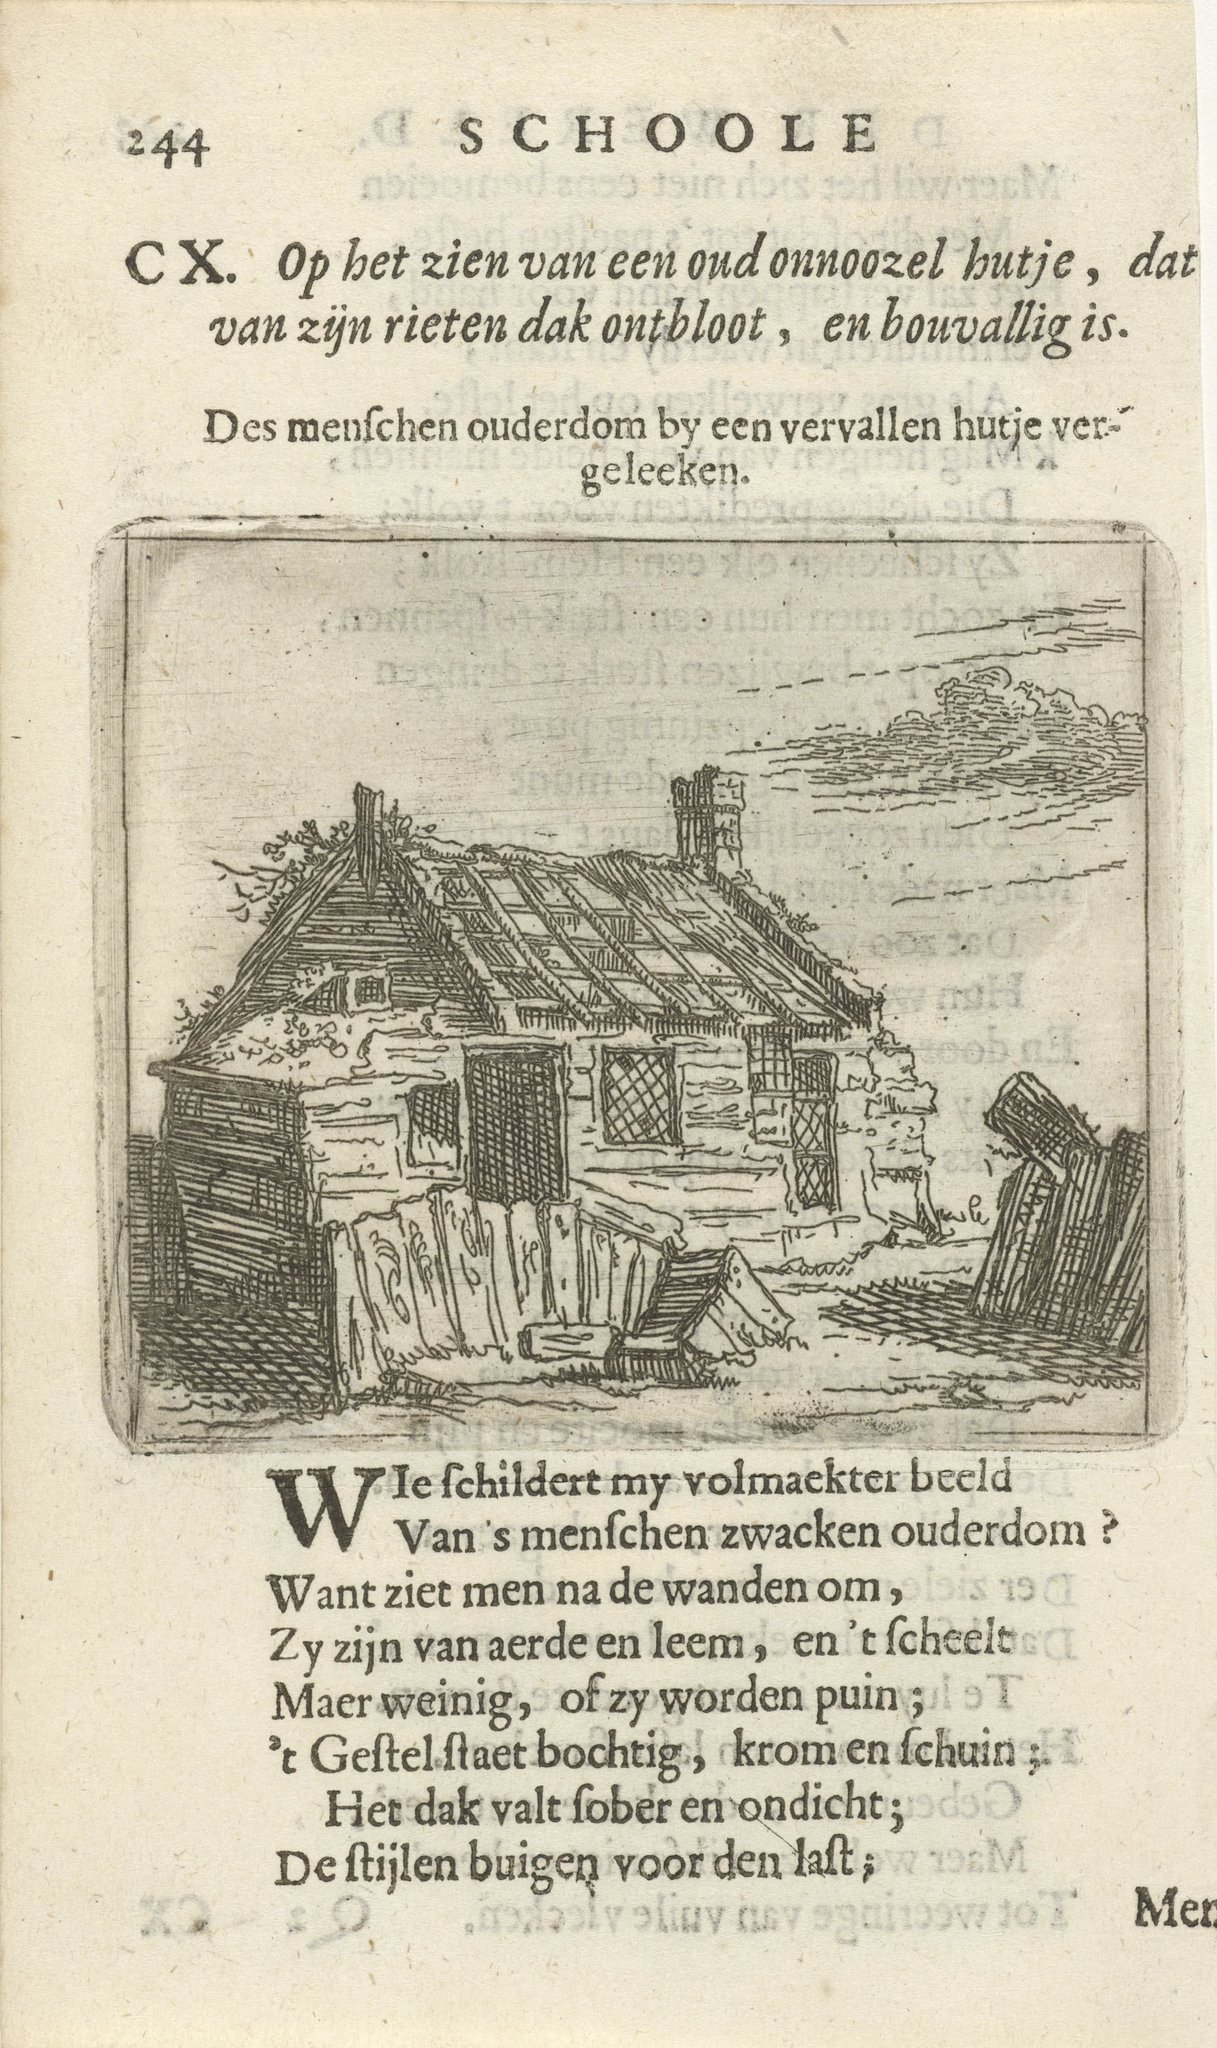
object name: book illustration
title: Vervallen huis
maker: arnold houbraken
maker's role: draughtsman, painter, print maker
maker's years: 1660-1719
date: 1682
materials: paper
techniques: etching, letterpress printing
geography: northern netherlands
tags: ruin of a dwelling, house, castle, etc.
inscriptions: collector's mark: Lugt 2228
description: Prent uit: Joseph Hall, [bewerkt door] François van Hoogstraeten, De schoole der wereld, geopent in CXL. vliegende bedenkingen op veelerhande voorvallende gezichten en zaeken. Dordrecht: François van Hoogstraeten, 1682. En in herdrukken in 1687 en 1725.